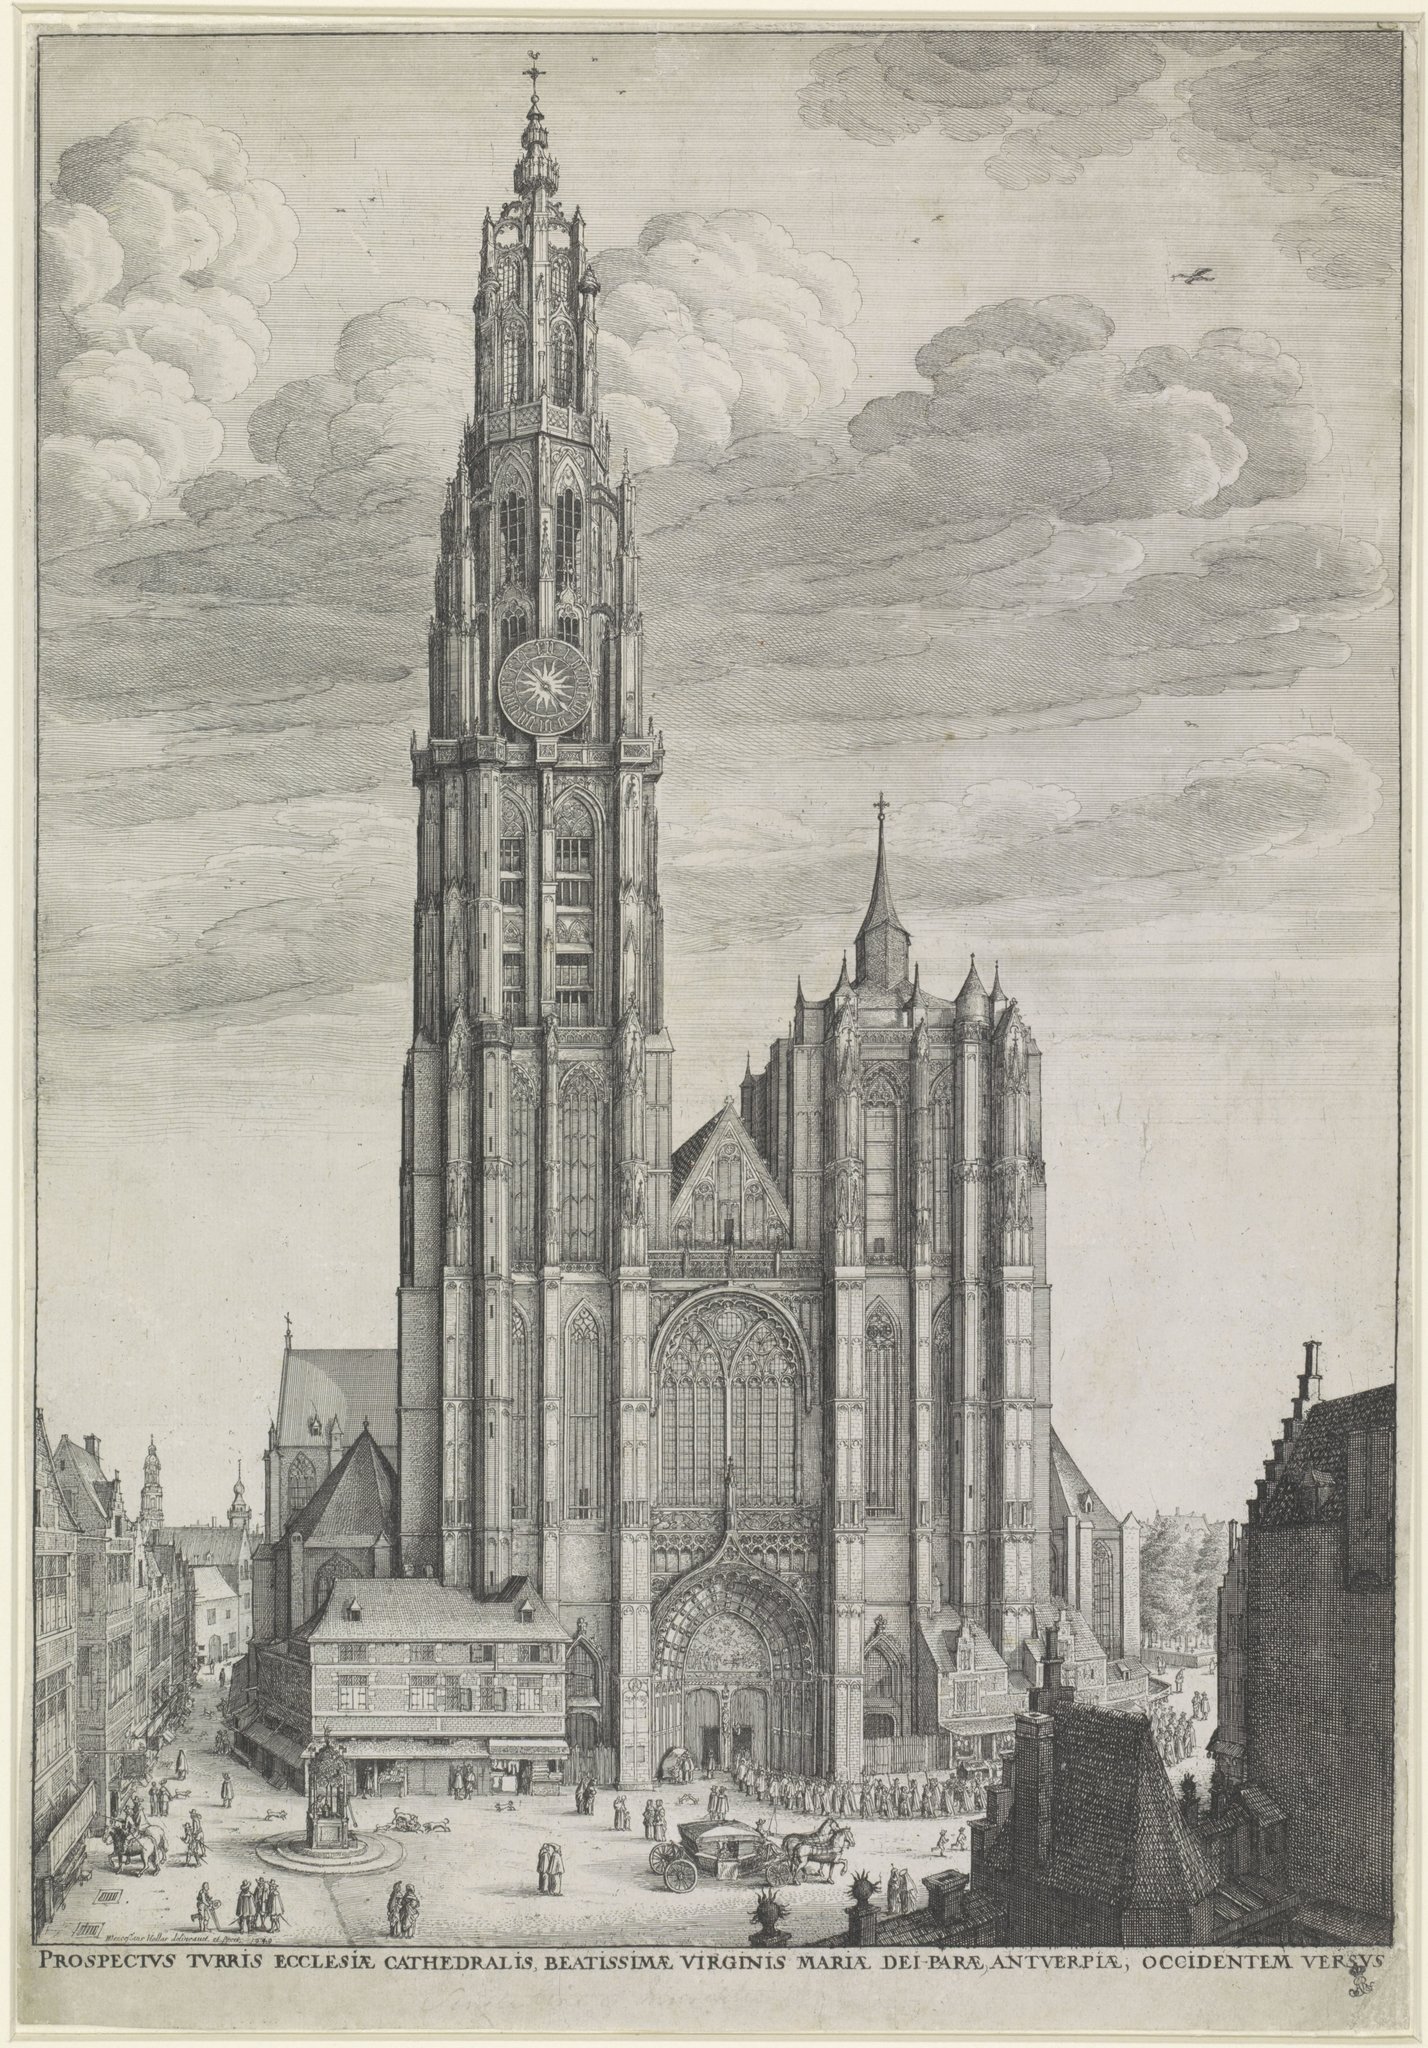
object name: print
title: Westgevel van de Onze-Lieve-Vrouwe-Kathedraal te Antwerpen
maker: wenceslaus hollar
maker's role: draughtsman, print maker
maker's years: 1607-1677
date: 1649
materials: paper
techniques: etching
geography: antwerp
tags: church (exterior)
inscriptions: collector's mark: Lugt 240, collector's mark: Lugt 166